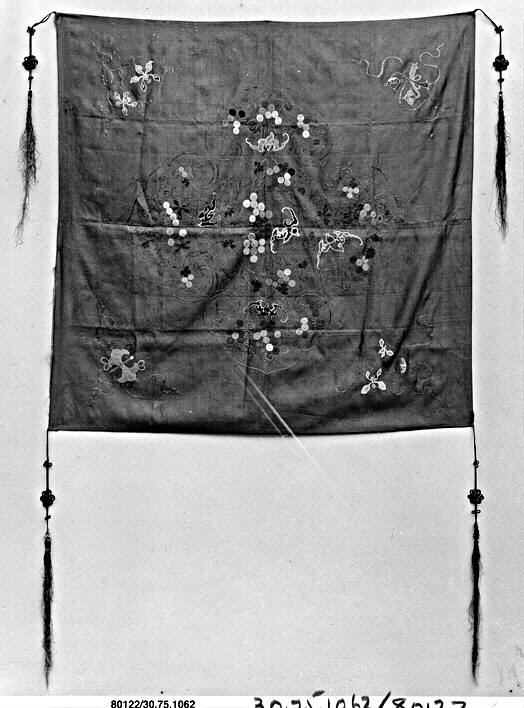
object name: furniture cover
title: Furniture Cover for Chair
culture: chinese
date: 1644-1911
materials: metal thread, silk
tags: bats